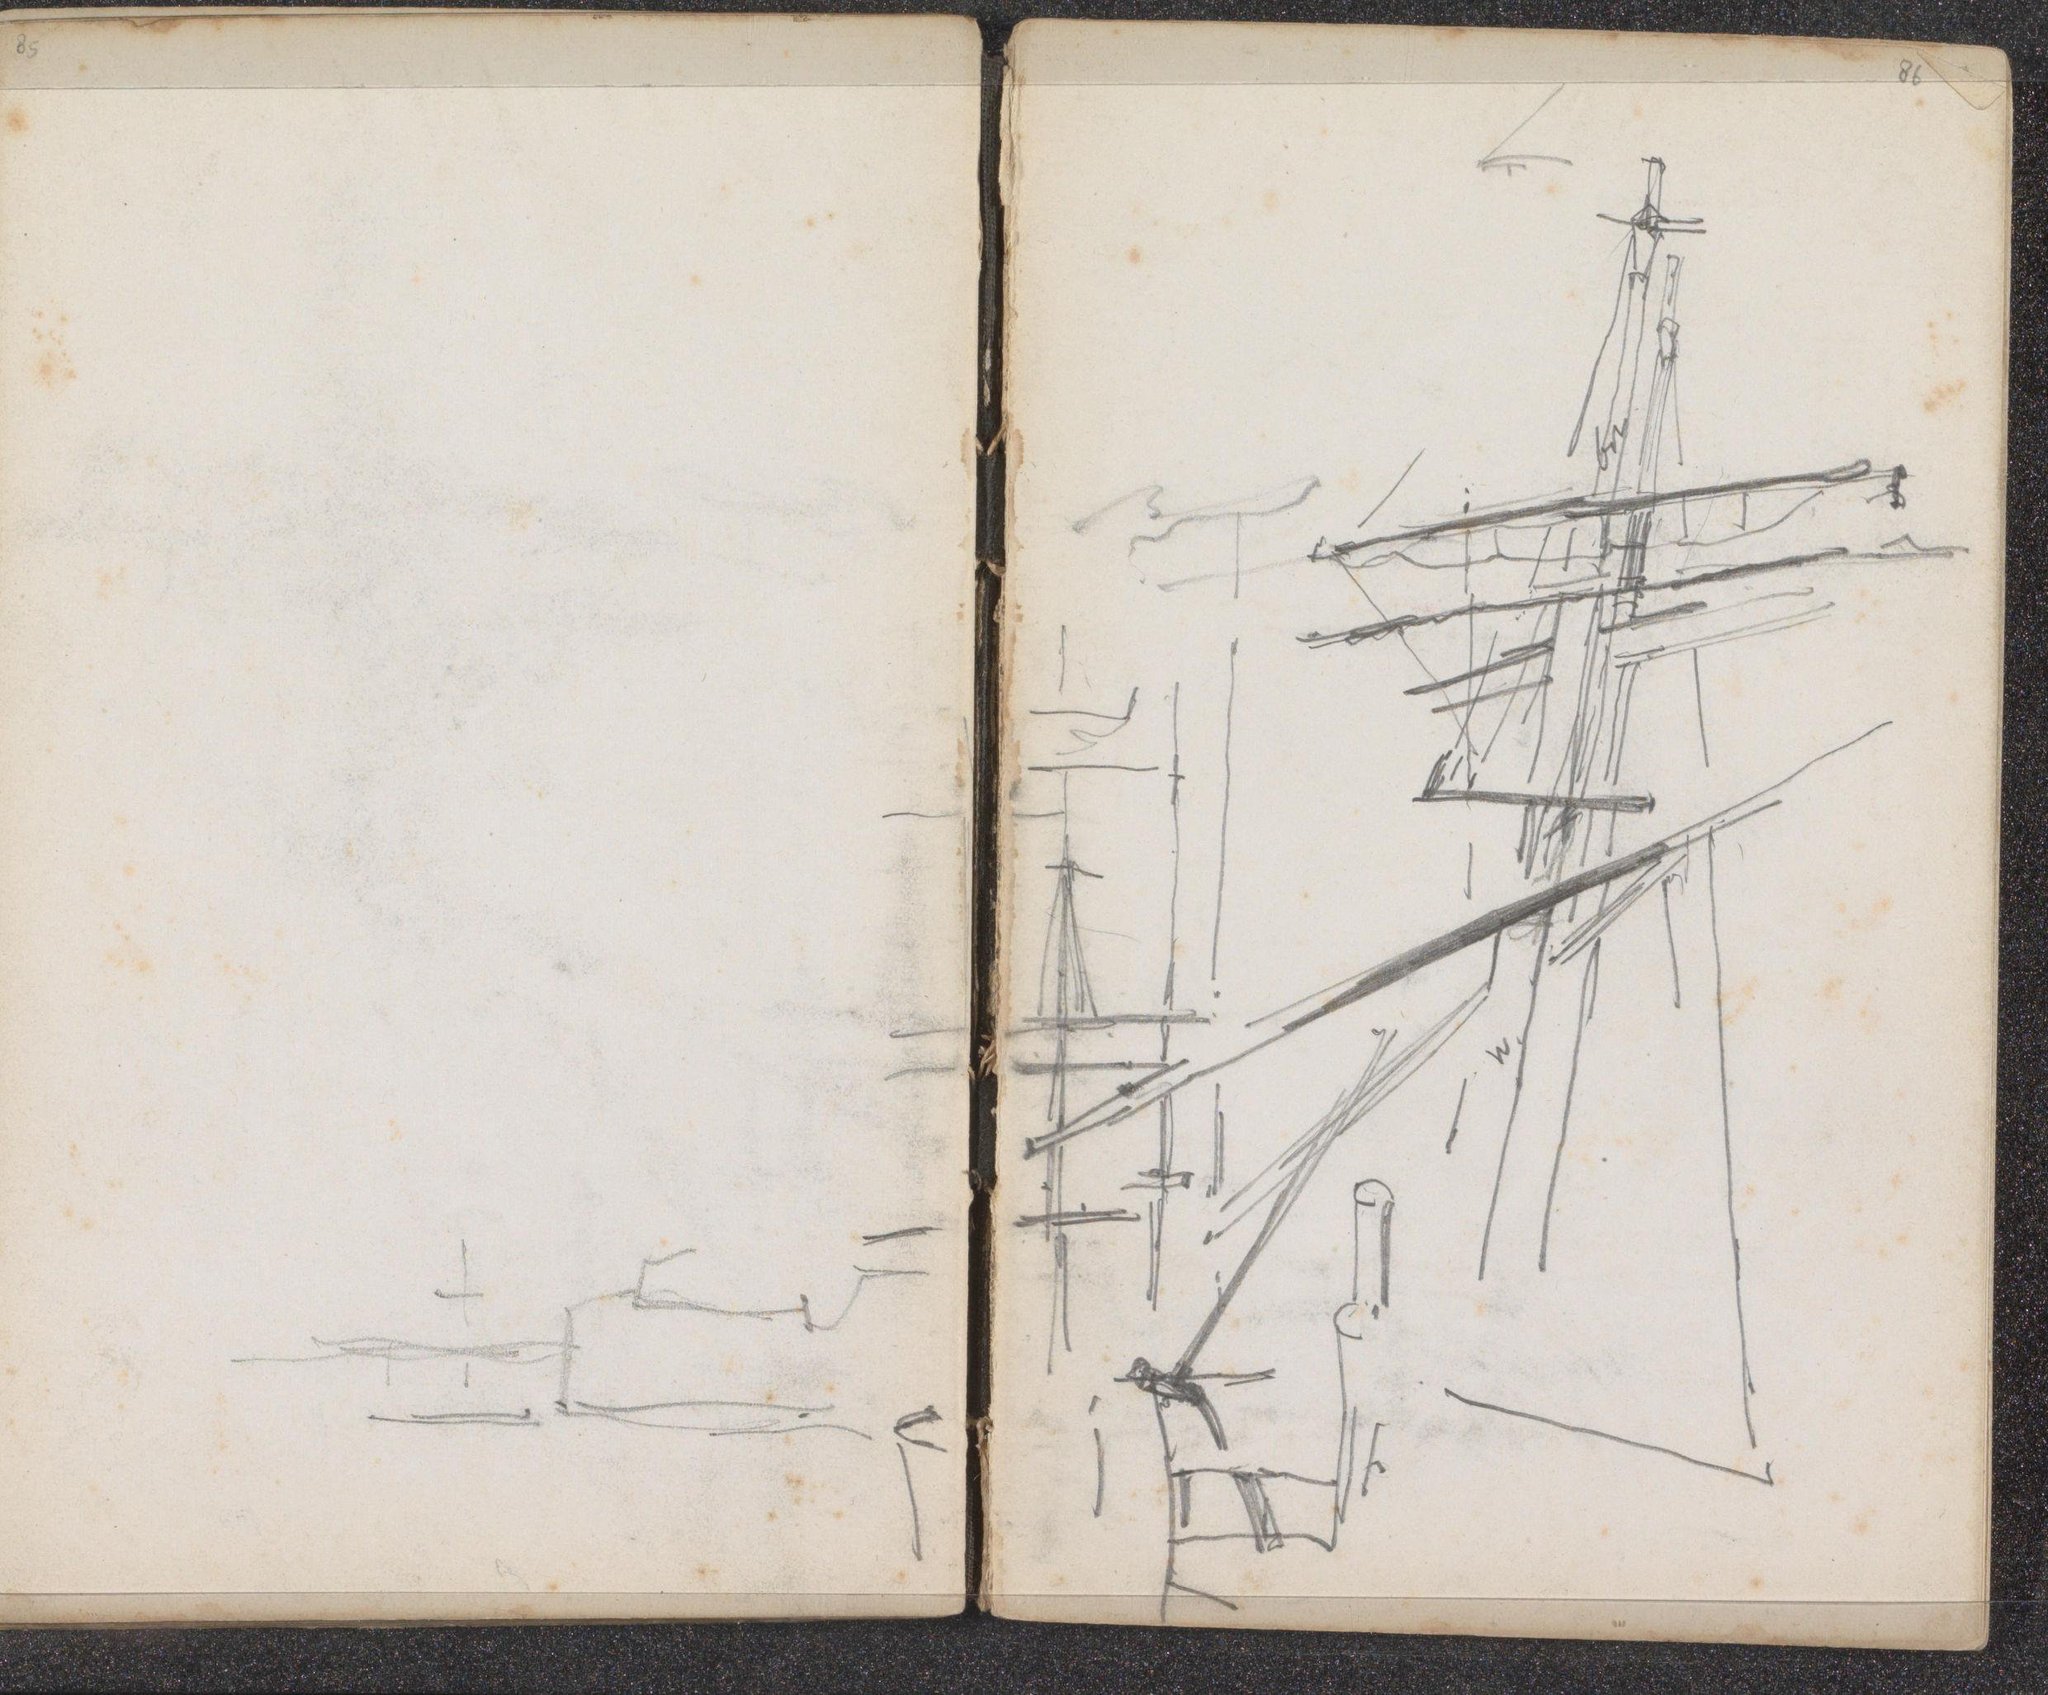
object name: sketchbook leaf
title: Schepen in de haven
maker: george hendrik breitner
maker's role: draughtsman, painter, print maker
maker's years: 1857-1923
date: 1880-1882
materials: paper, pencil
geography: south holland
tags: harbour, ships (in general)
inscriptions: kleurnotitie, handgeschreven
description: Pagina 85 en pagina 86 uit een schetsboek met 72 bladen.